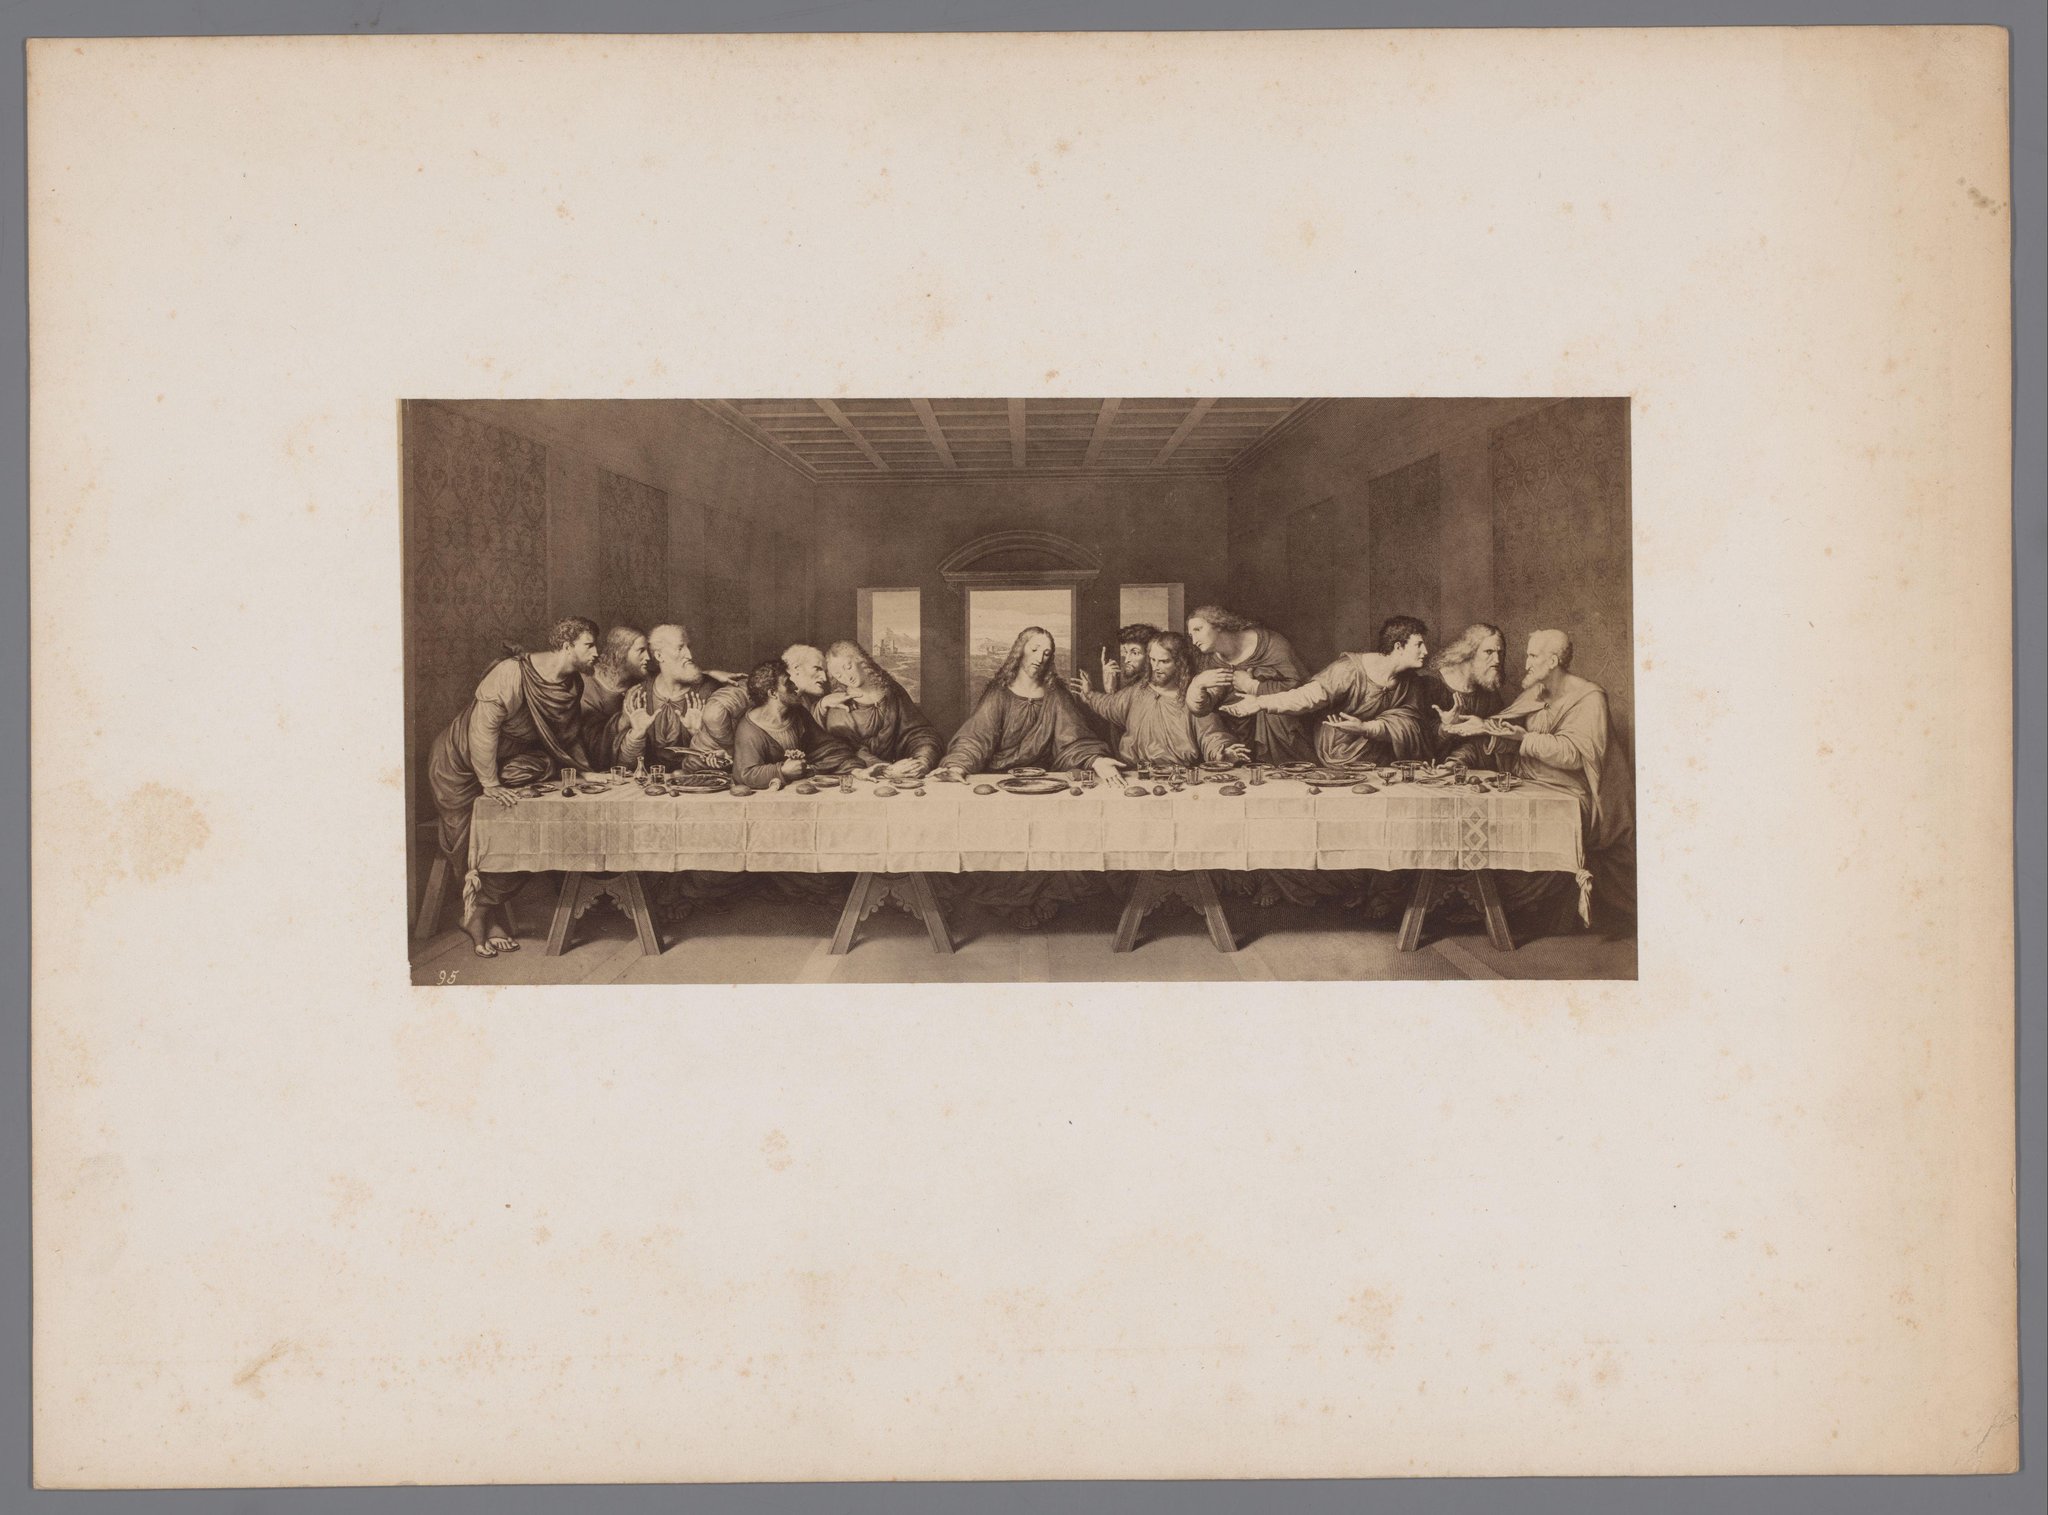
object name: photograph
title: Il Cenacolo van Leonardo da Vinci, foto naar gravure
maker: Anonymous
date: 1850-1900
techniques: albumen print